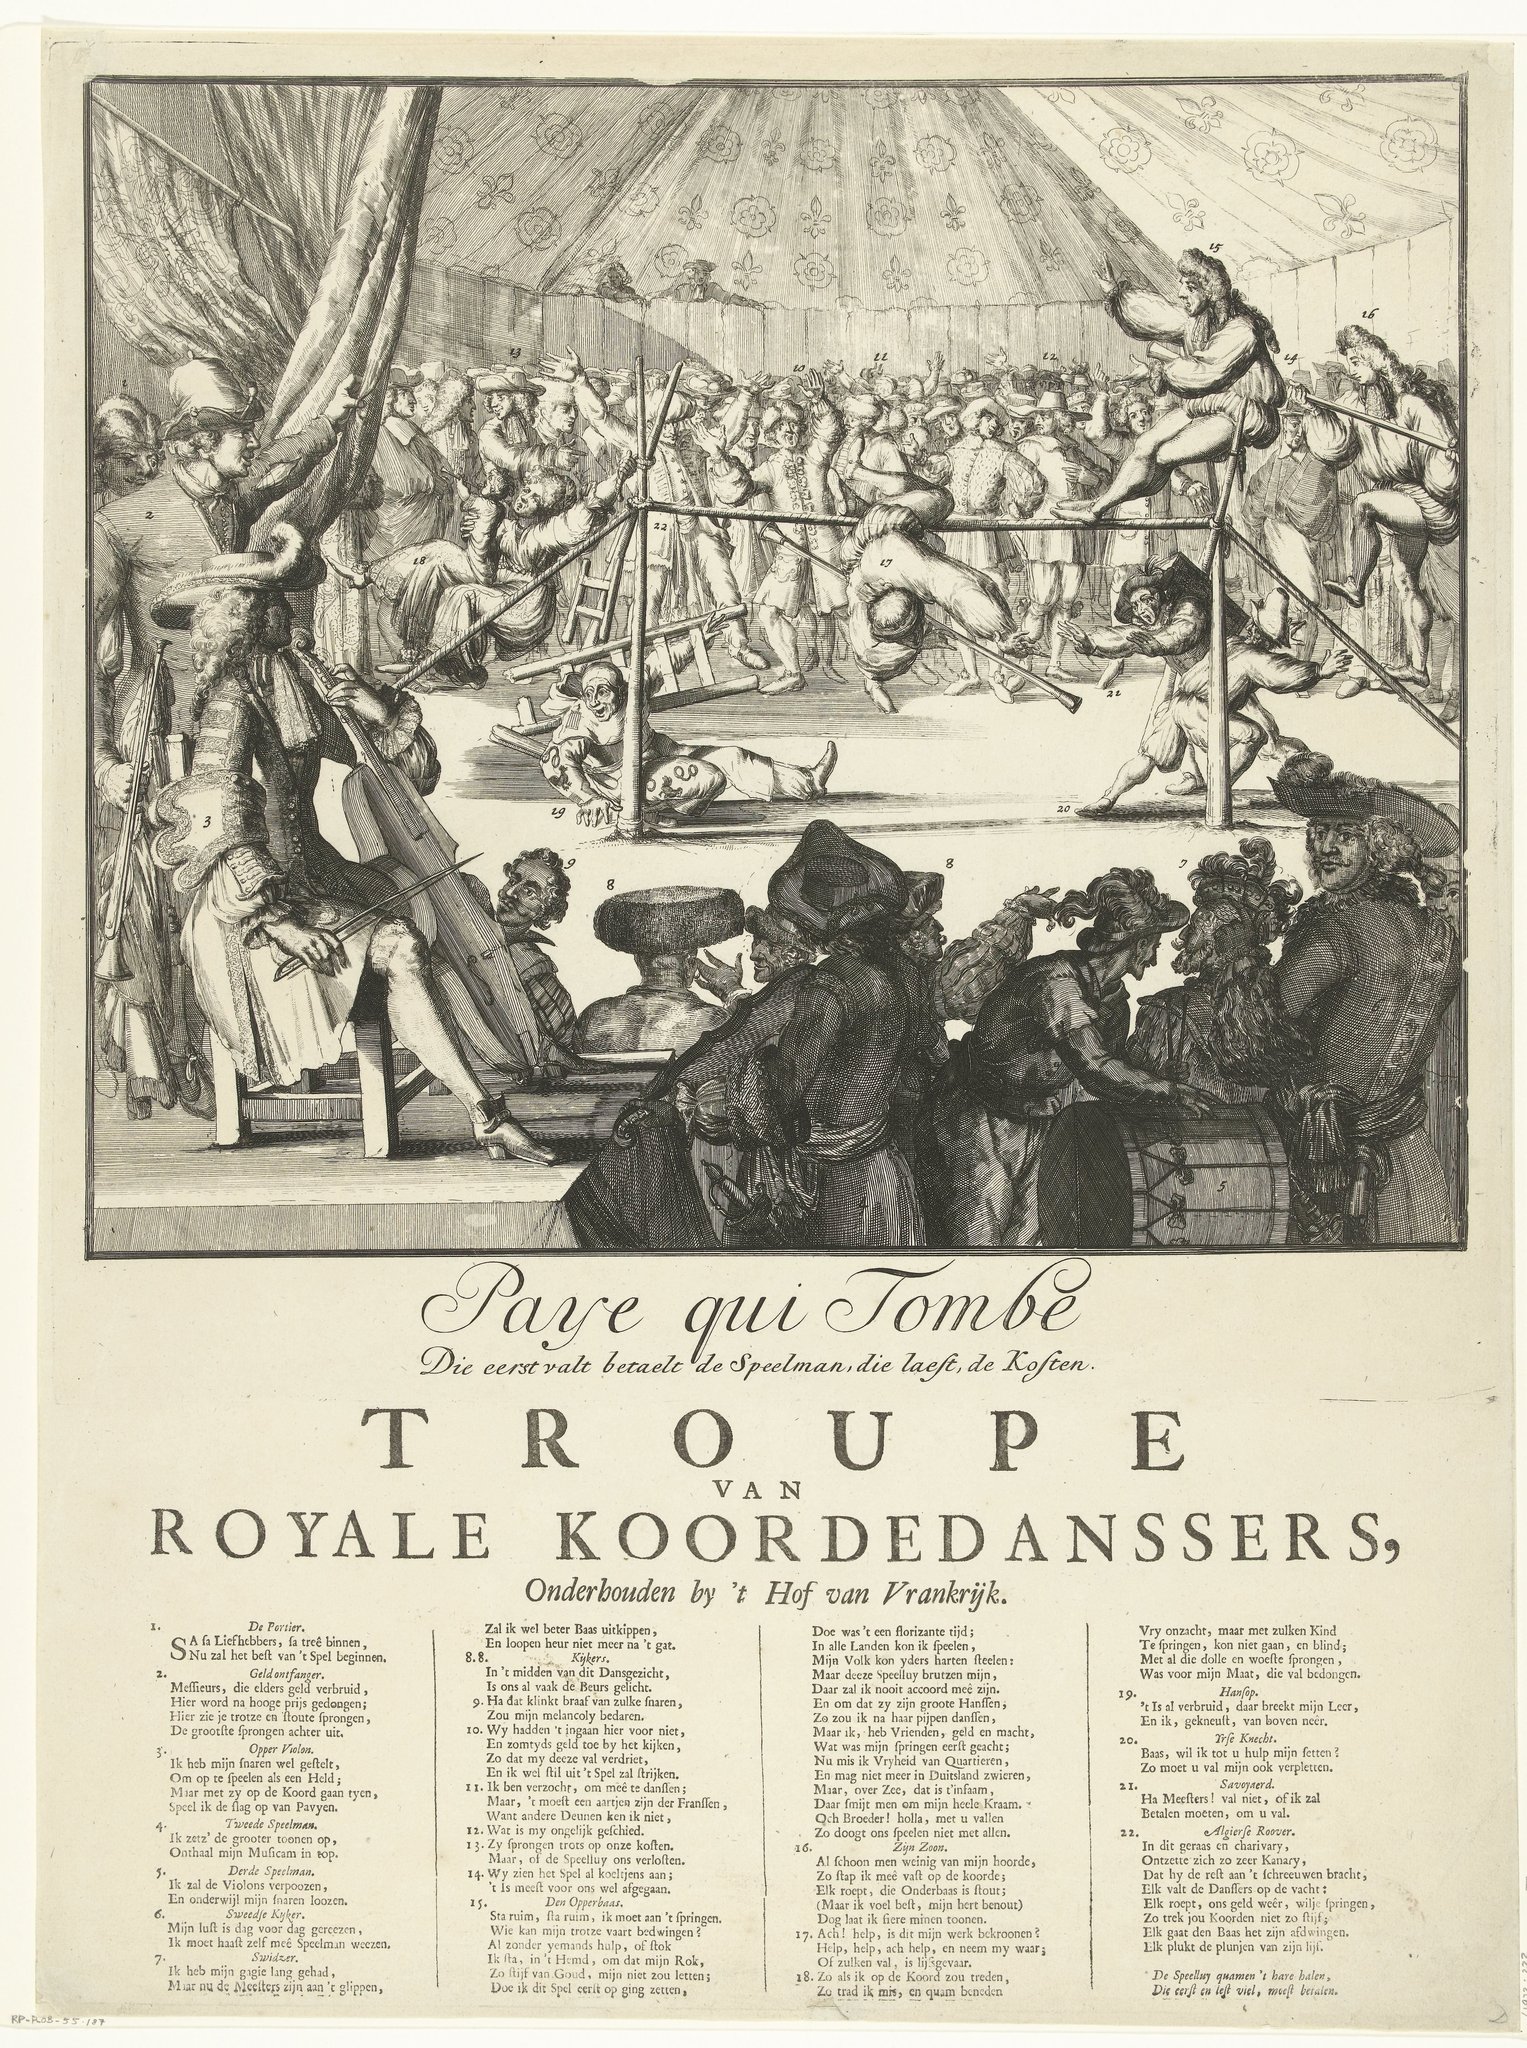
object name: print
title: He who falls first pays the player, the last, the costs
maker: romeyn de hooghe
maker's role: draughtsman, goldsmith, painter, print maker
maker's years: 1645-1708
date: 1689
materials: paper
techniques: engraving, etching, letterpress printing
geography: netherlands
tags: jacobus ii (koning van engeland en schotland), the hague, william iii (prince of orange and king of england, scotland, and ireland), lodewijk xiv (koning van frankrijk), paris, dauphin van frankrijk lodewijk, london, rome, small group of musicians, chamber orchestra, jazz band, drum (musical instrument), viola, violoncello; double bass, tight-ropewalker, the show; fair and circus performers (+ music and song ~ festive activities)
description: Here, we see the Catholic monarchs recast as tightrope walkers in a circus, performing a balancing act to stay in power. This metaphor illustrates their precarious situation in a way that viewers can easily understand. Stadtholder-King William III provides musical accompaniment for the dance. As King James II of England tumbles from the tightrope, Louis XIV steps up to try his skill.